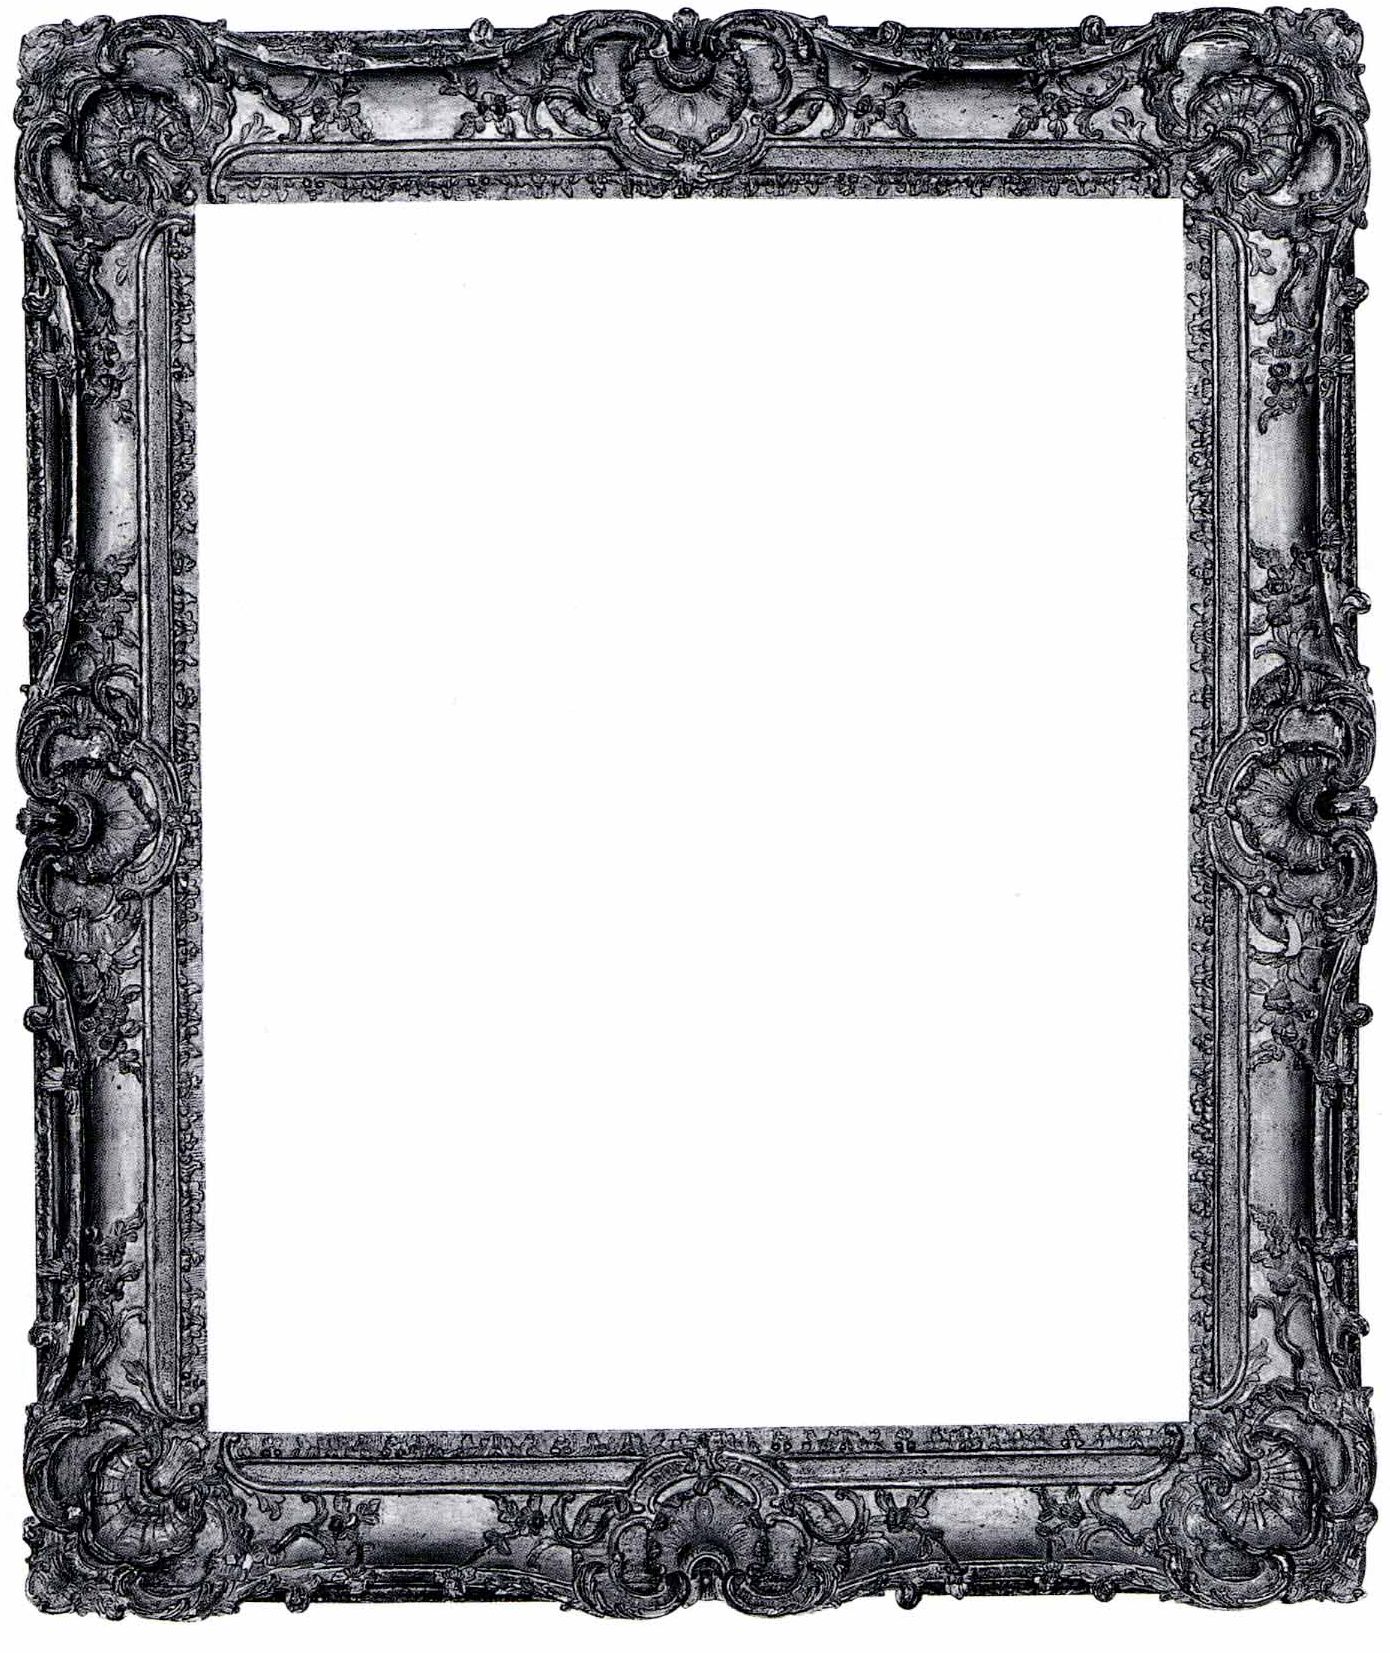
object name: frame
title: Swept frame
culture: french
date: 1735-1745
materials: gilt, wood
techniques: carving